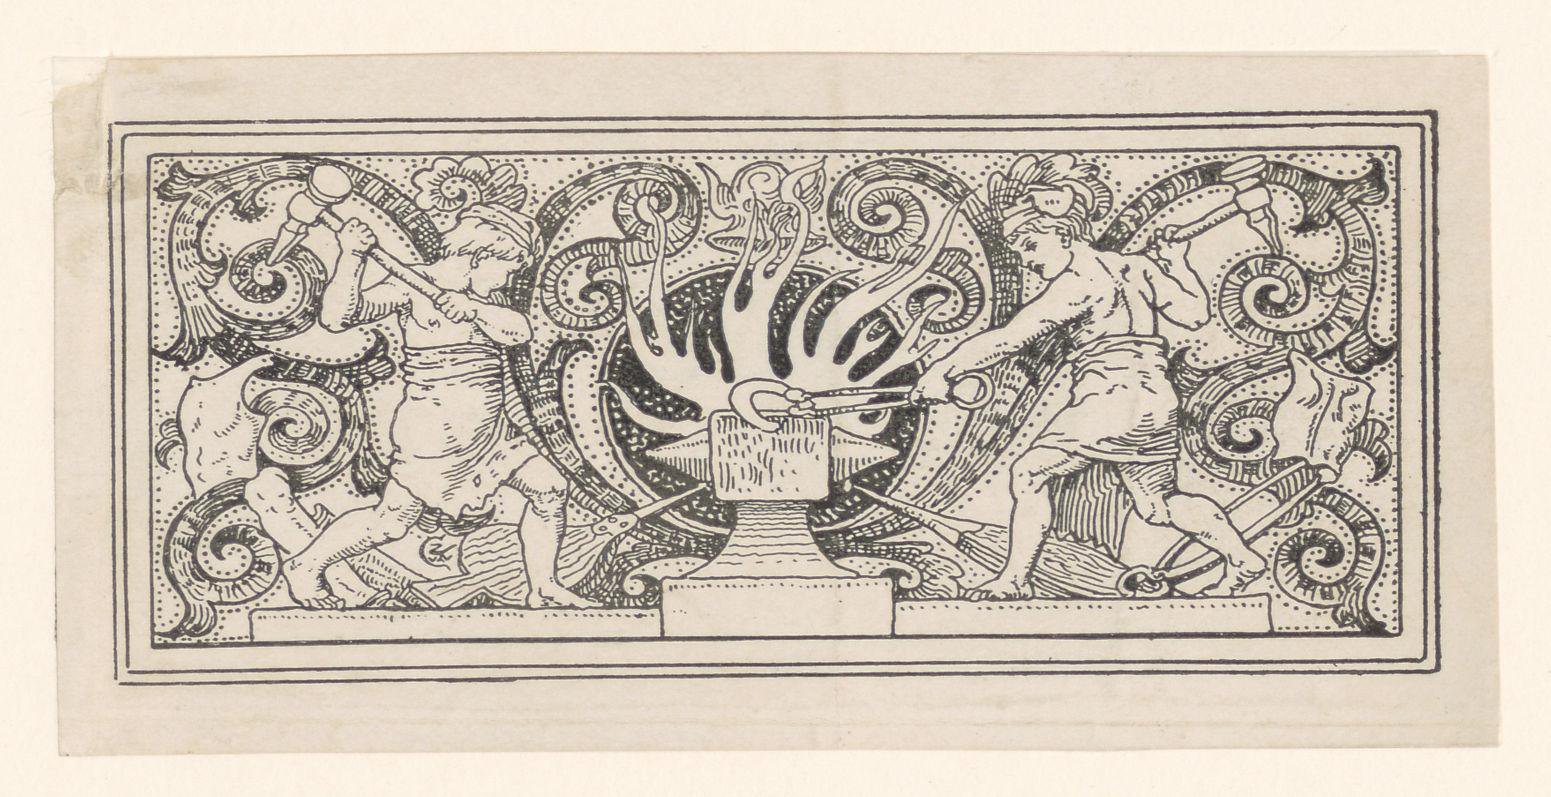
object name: print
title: Twee putti smeden een hoefijzer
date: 1887-1893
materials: paper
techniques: engraving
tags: handicrafts ~ metal, cupids: 'amores', 'amoretti', 'putti', tools, aids, implements ~ crafts and industries: anvil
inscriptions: collector's mark: Lugt 2228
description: De prent is gebruikt in: Crane, Walter. The claims of decorative art. Londen: Lawrence & Bullen, 1892.